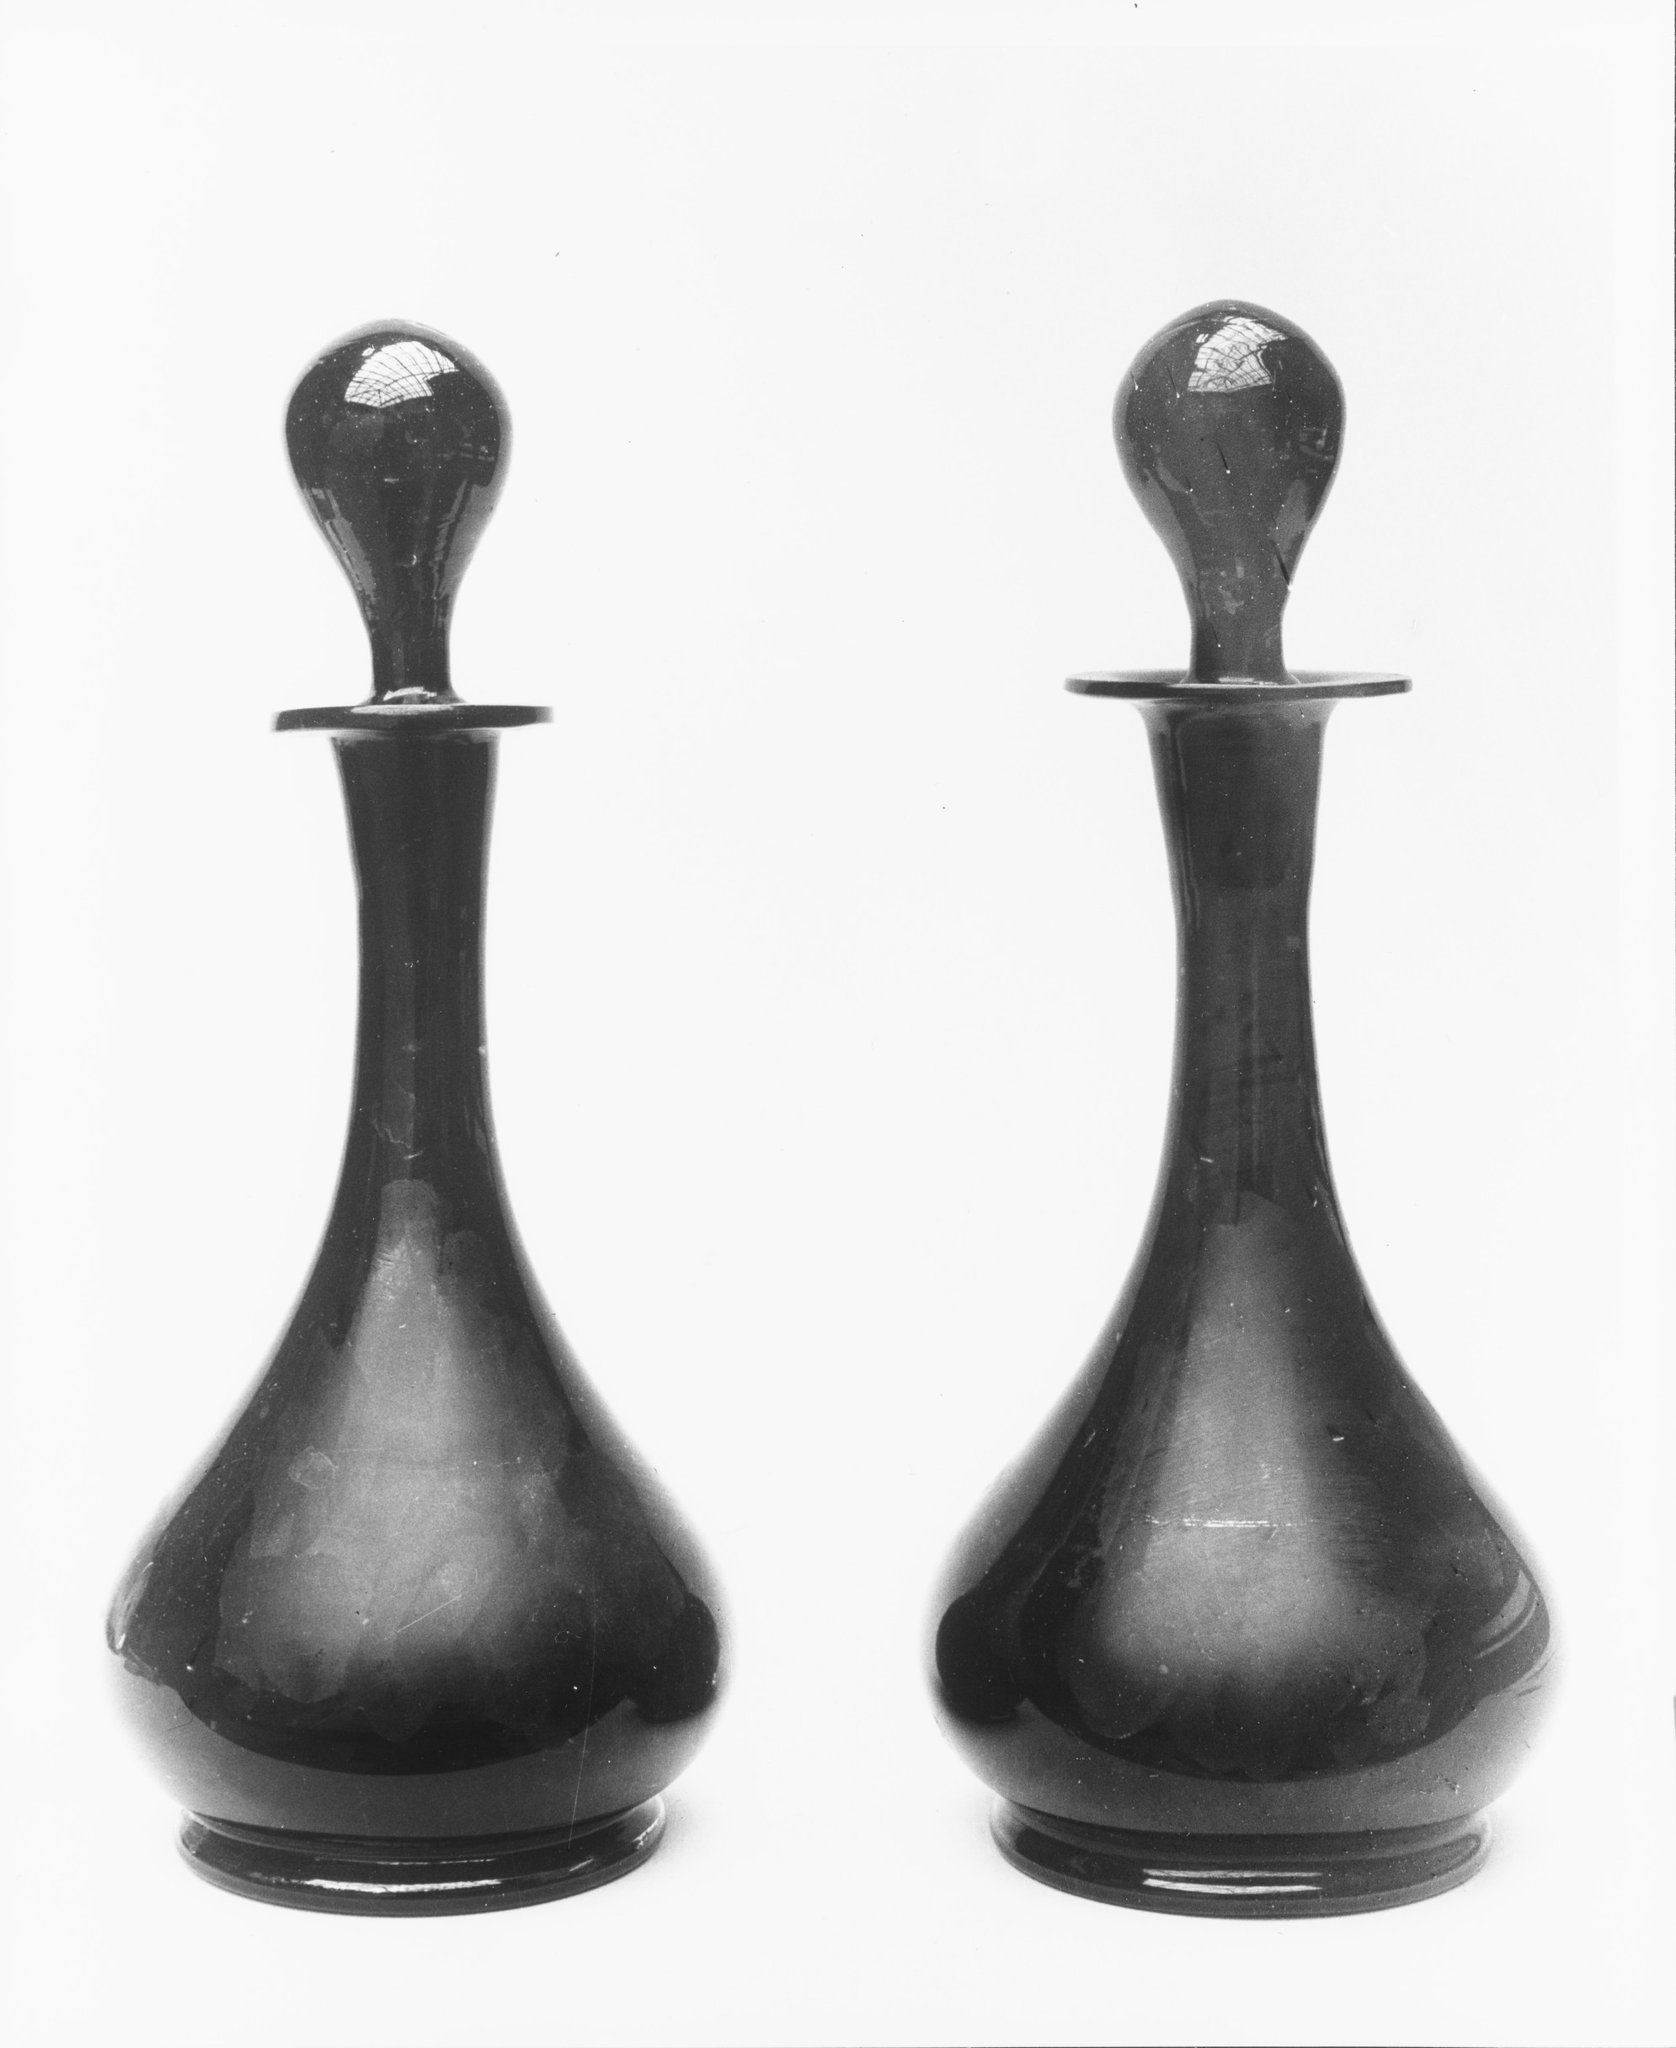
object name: cologne bottle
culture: czech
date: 1870-1900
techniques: glassblowing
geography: czech republic